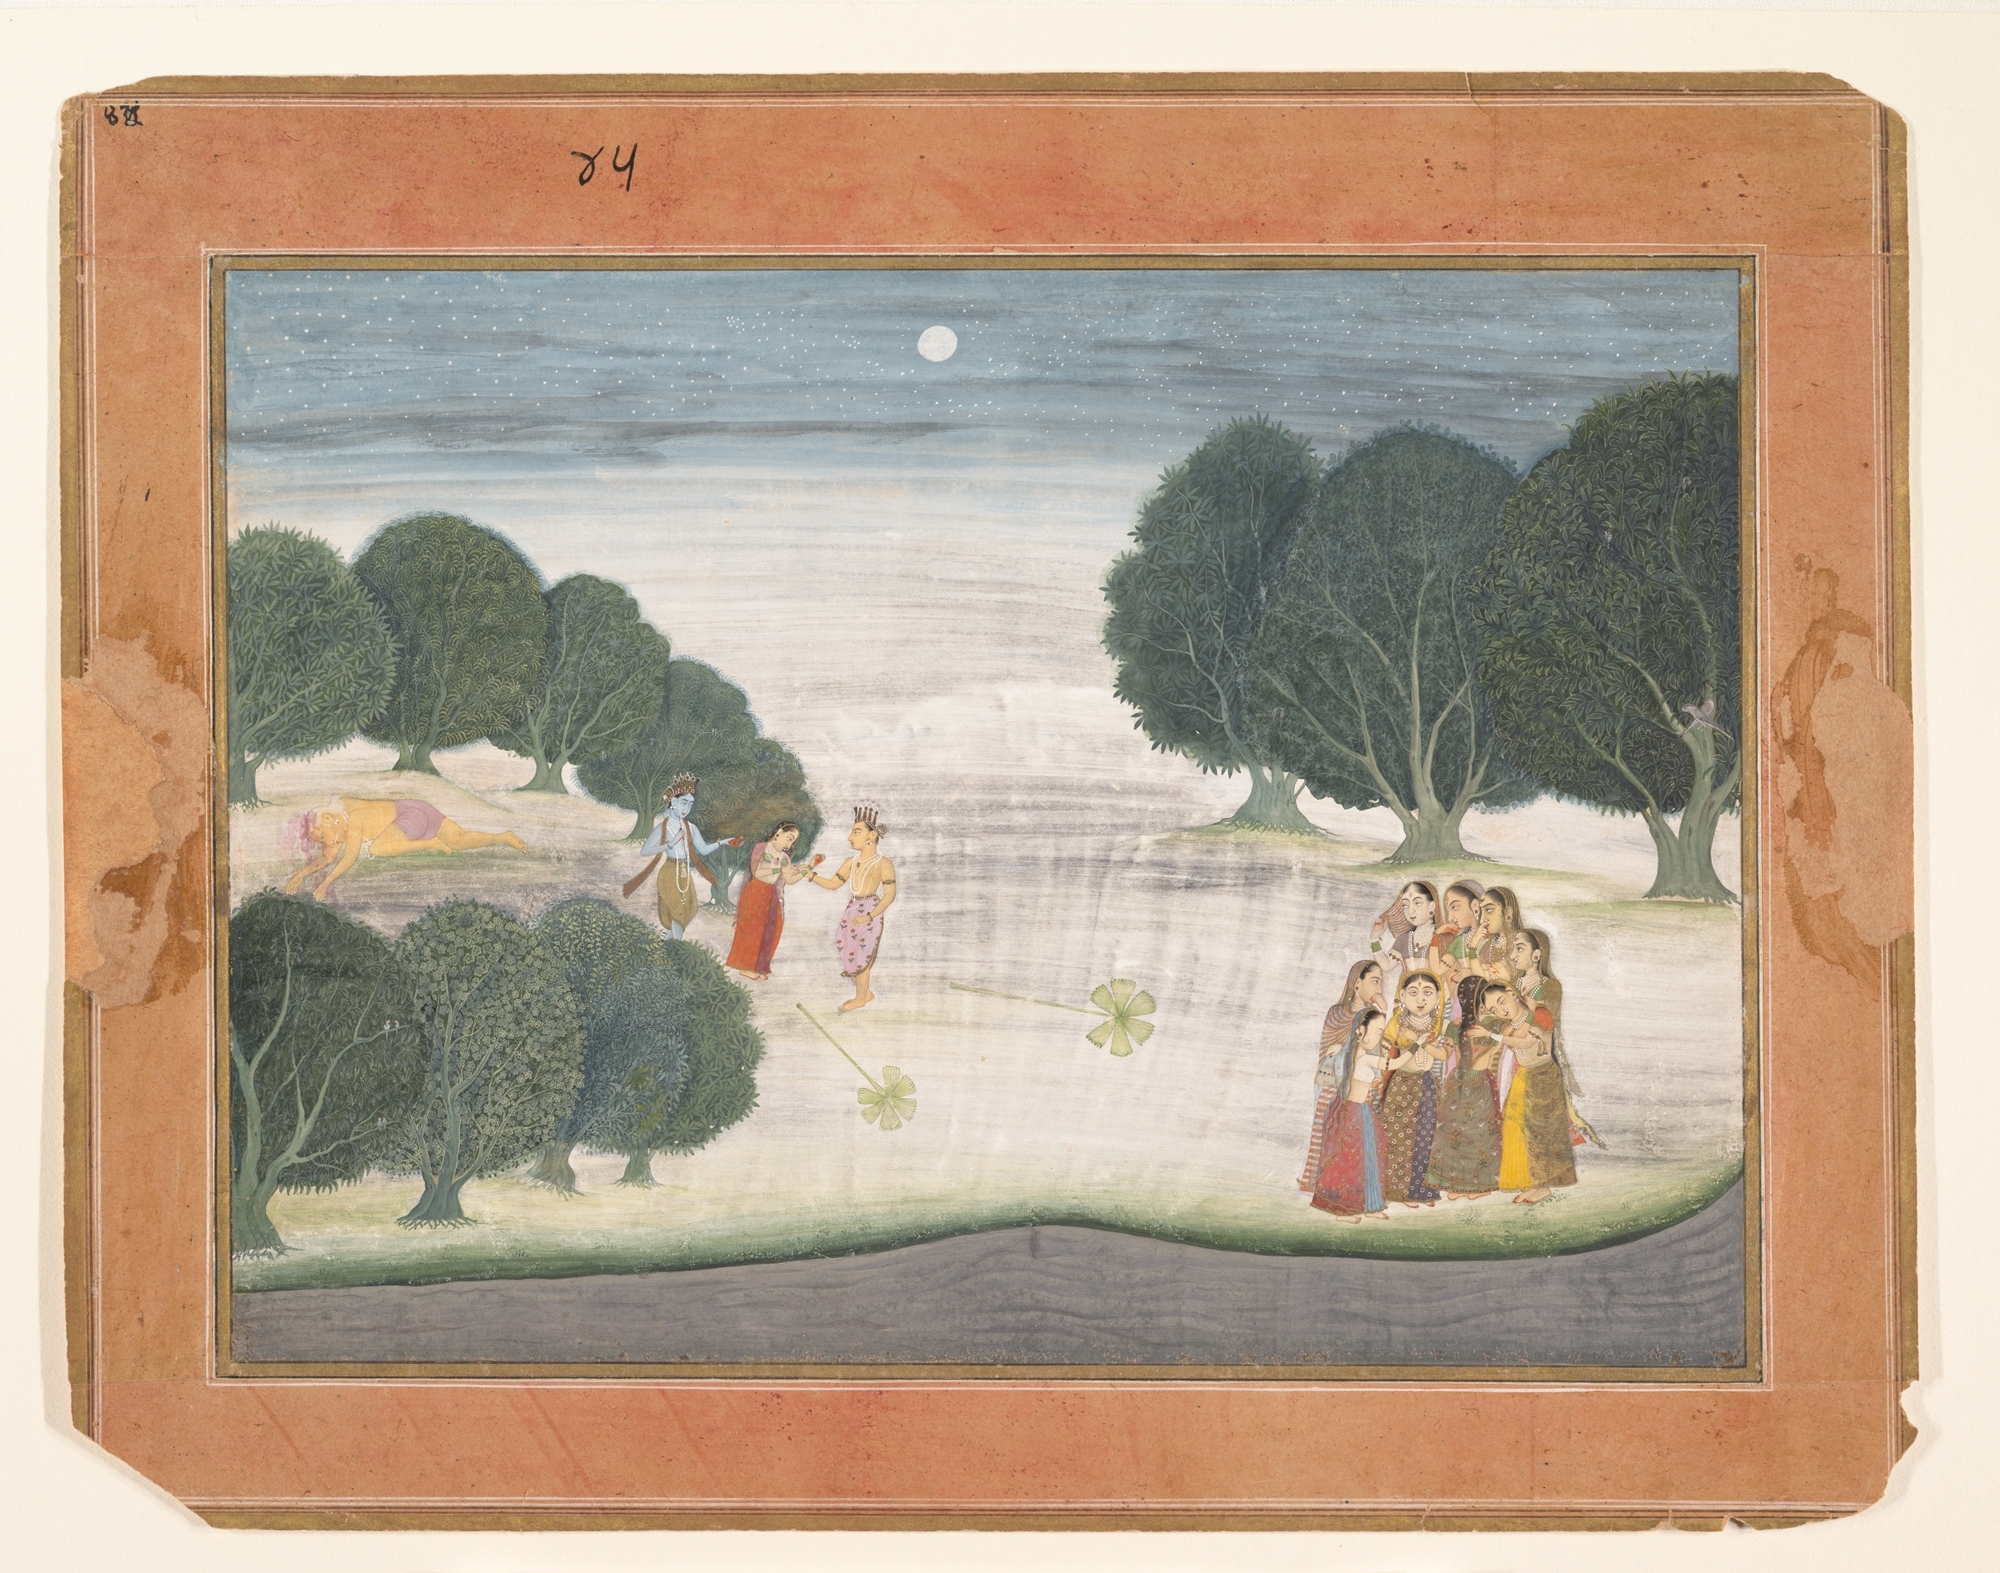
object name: folio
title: The Death of the Giant Shankachura: Page from a Dispersed Bhagavata Purana (Ancient Stories of Lord Vishnu)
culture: indian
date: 1680-1690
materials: ink, paper, watercolor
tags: women,krishna,hinduism,death